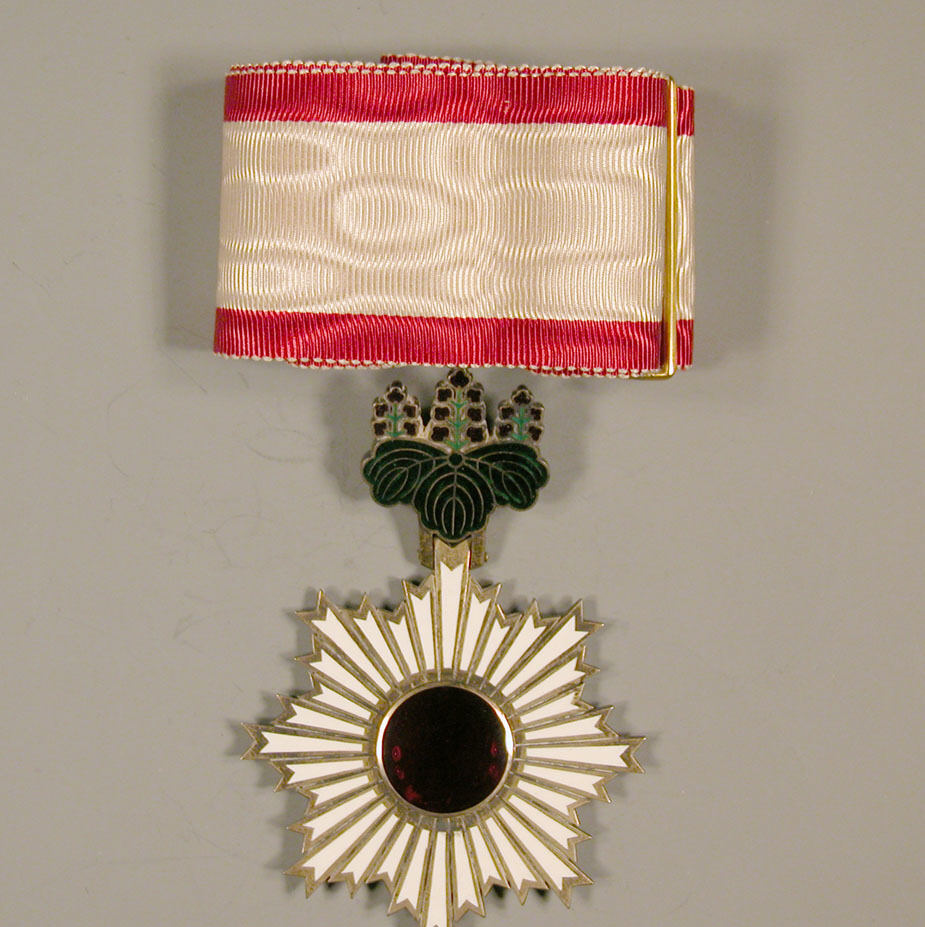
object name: insignia, medal and button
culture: japanese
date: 1867-1900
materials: ribbon, silver